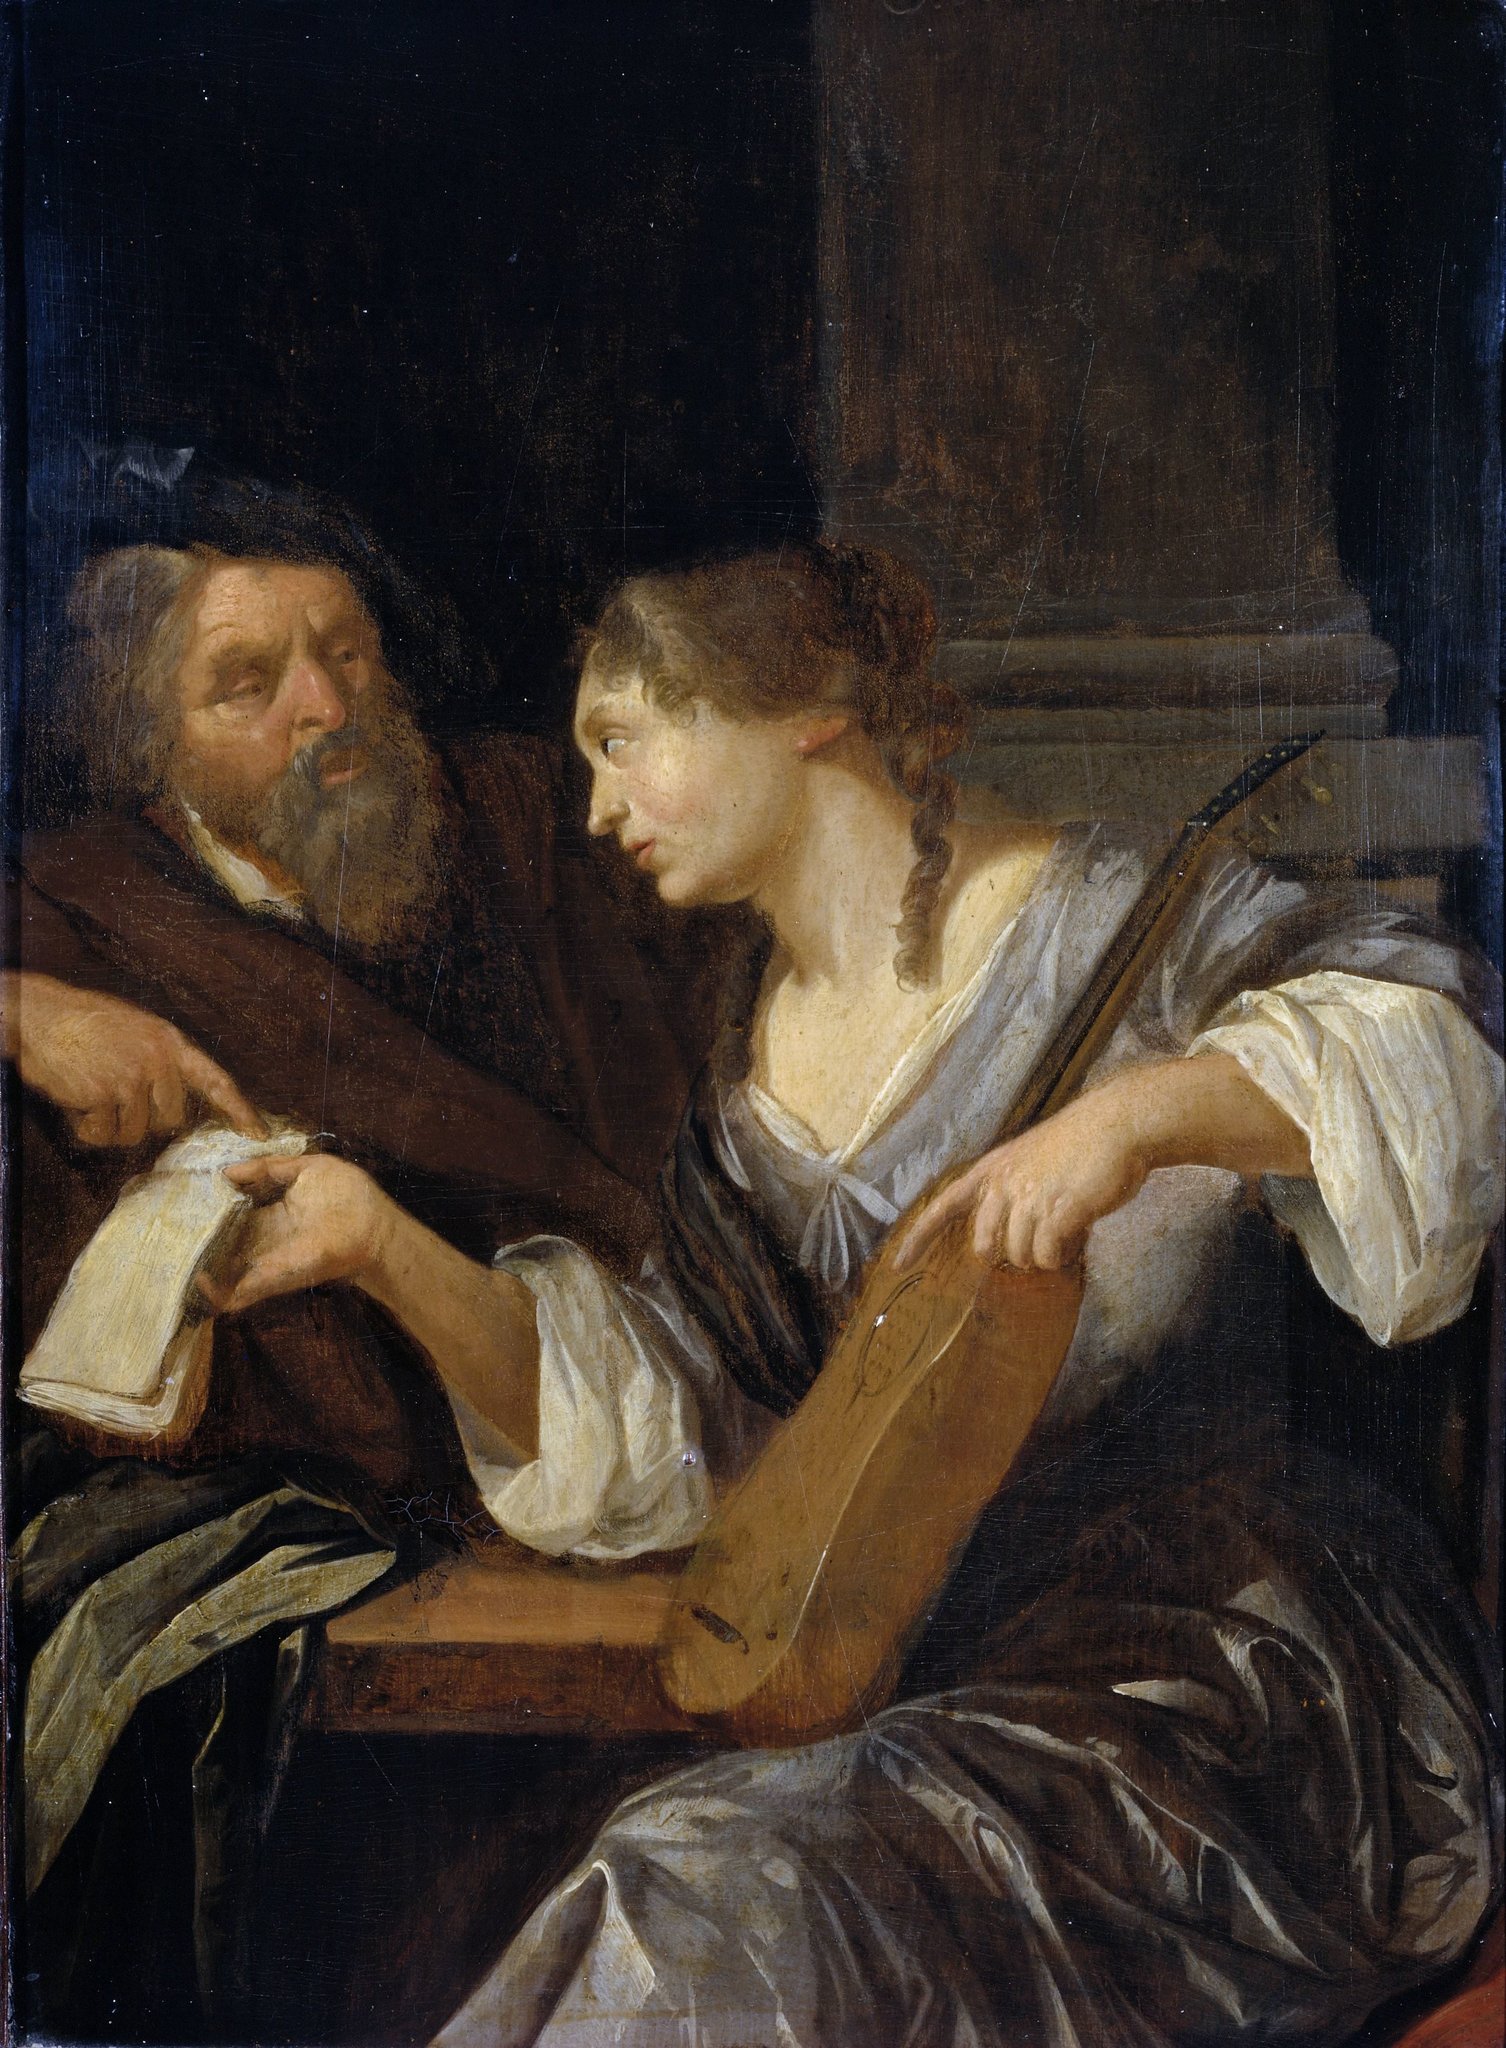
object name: painting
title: The music lesson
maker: jacob toorenvliet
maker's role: draughtsman, painter, print maker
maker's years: 1640-1719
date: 1660-1690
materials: oil, panel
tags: musician training pupils, music-lesson, cithern, mandolin, guitar, balalaika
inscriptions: signature: ‘J.Toornvliet f.’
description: De muziekles. Een oude man met baard geeft een jonge vrouw les in het spelen op een gitaar. De vrouw heeft een muziekboek in haar rechterhand.